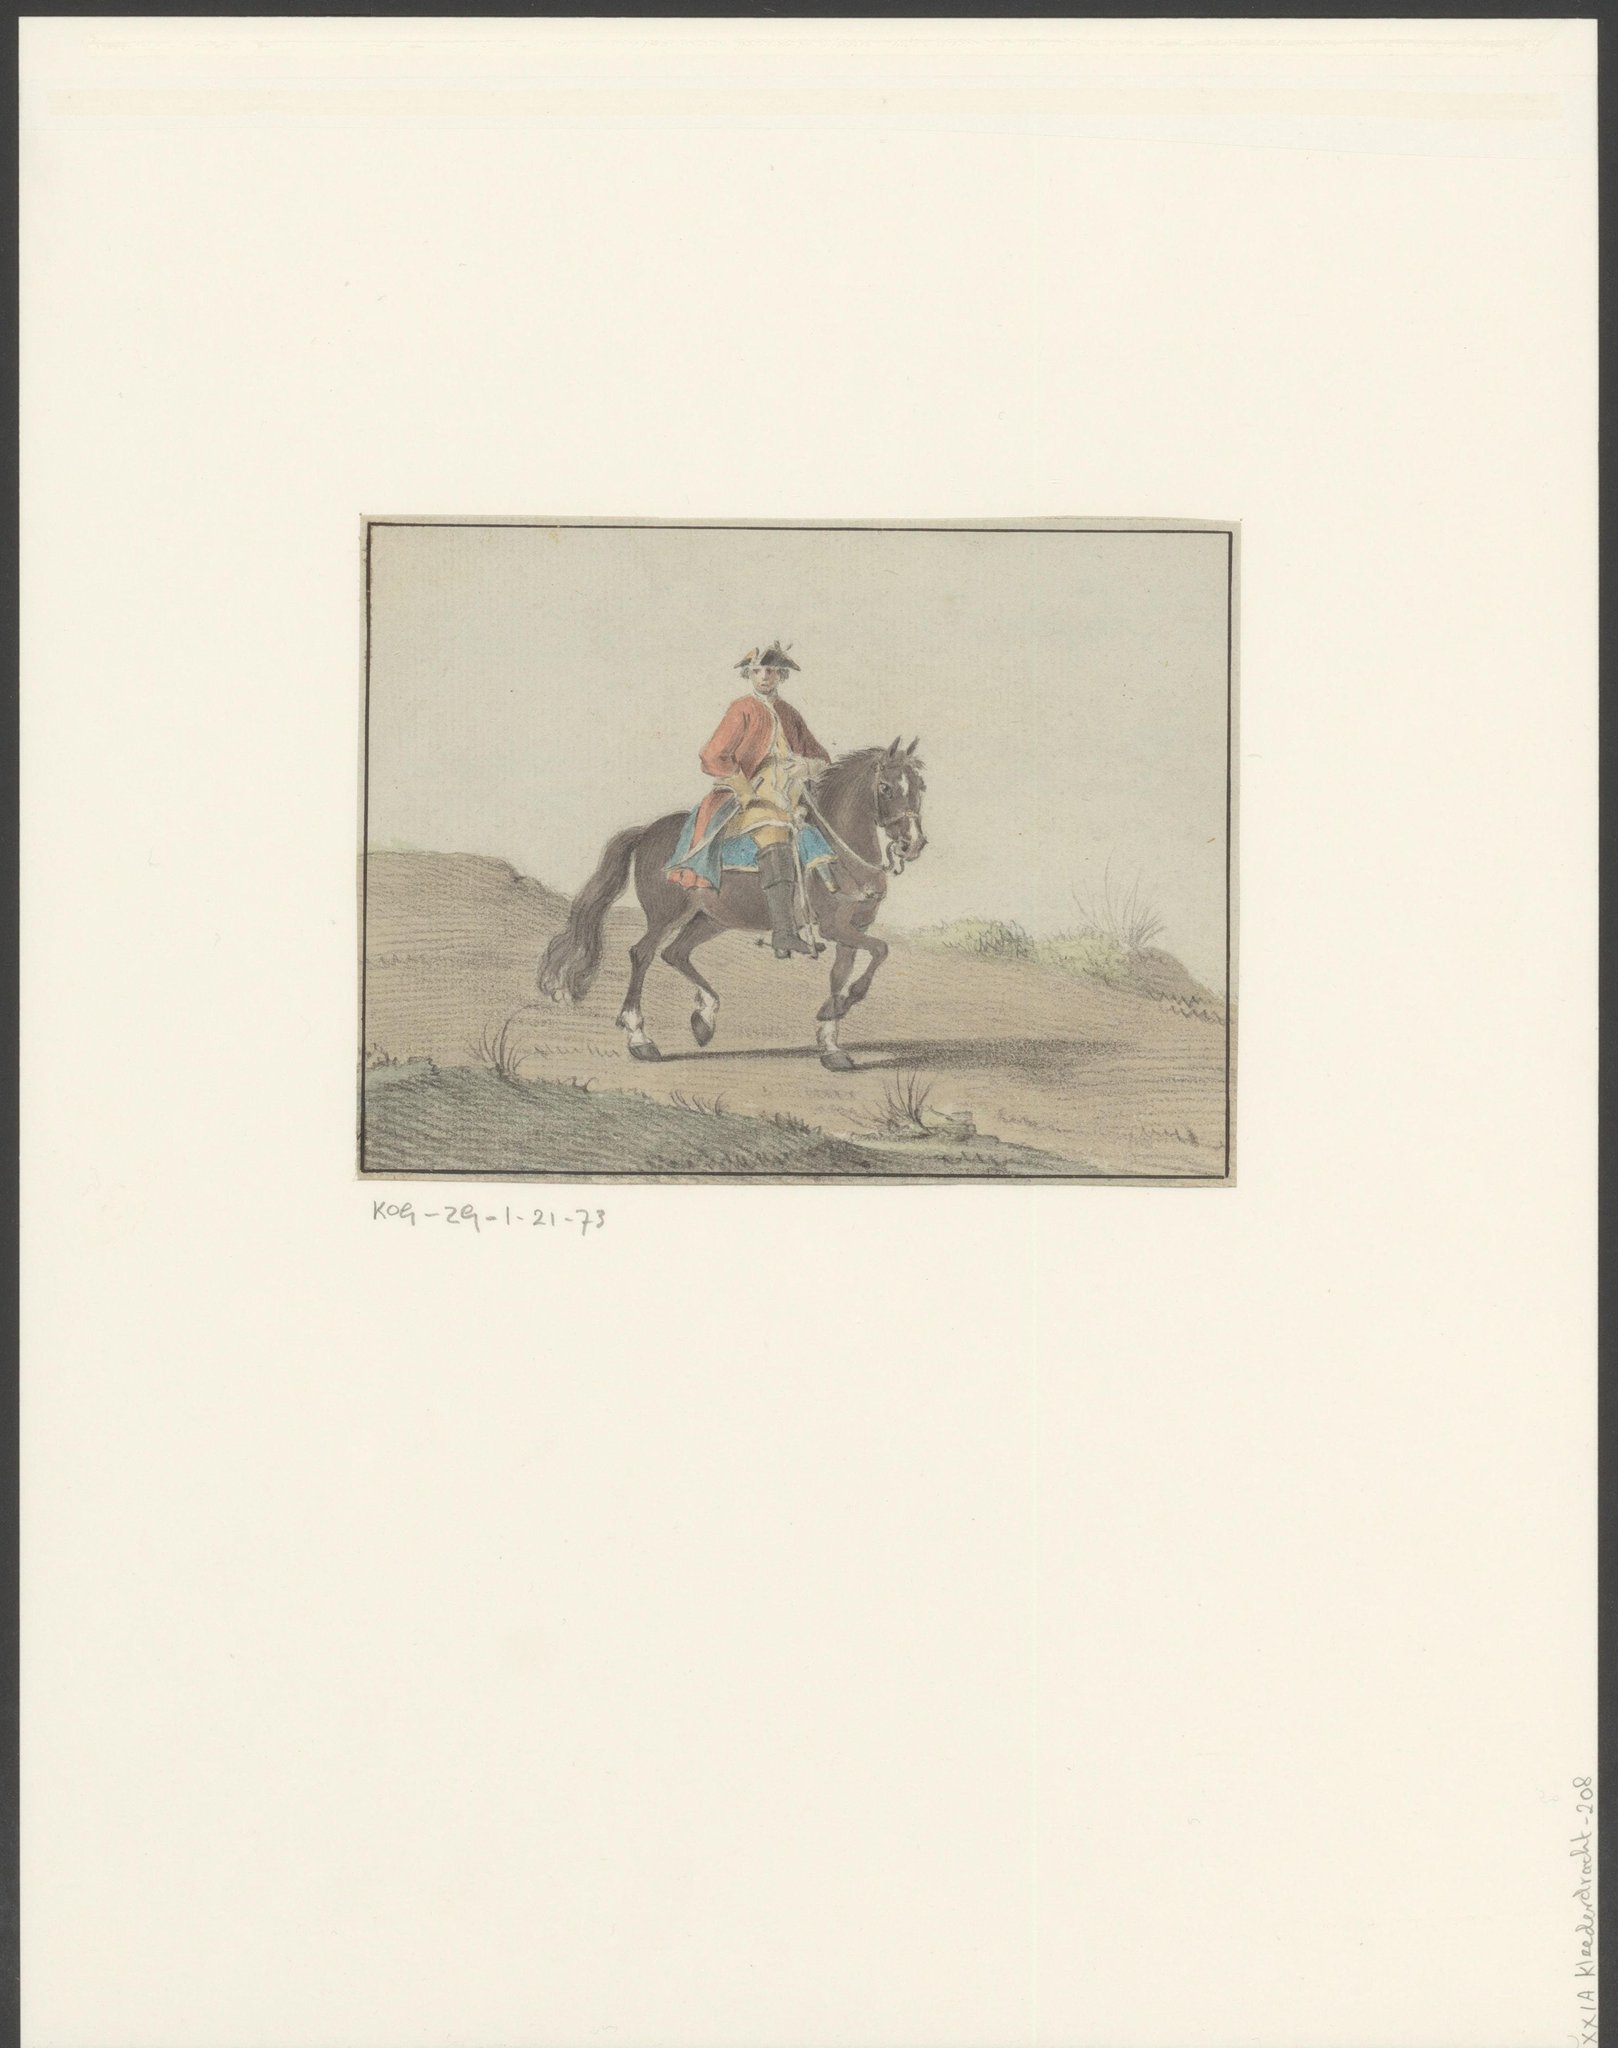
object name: drawing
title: Man te paard in rijkostuum met driekantige steek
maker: Anonymous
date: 1700-1799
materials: chalk, paper, watercolor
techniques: brush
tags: riding a horse, ass, or mule; rider, horseman, clothes, costume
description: Onderwerpsrubrieken binnen de Atlas Zeden en Gewoonten: Zeden en Gewoonten in Engeren Zin, De Kleeding, Kleederdrachten (tijdvakken), De 18de eeuw (de pruikentijd). Mannen en vrouwen.